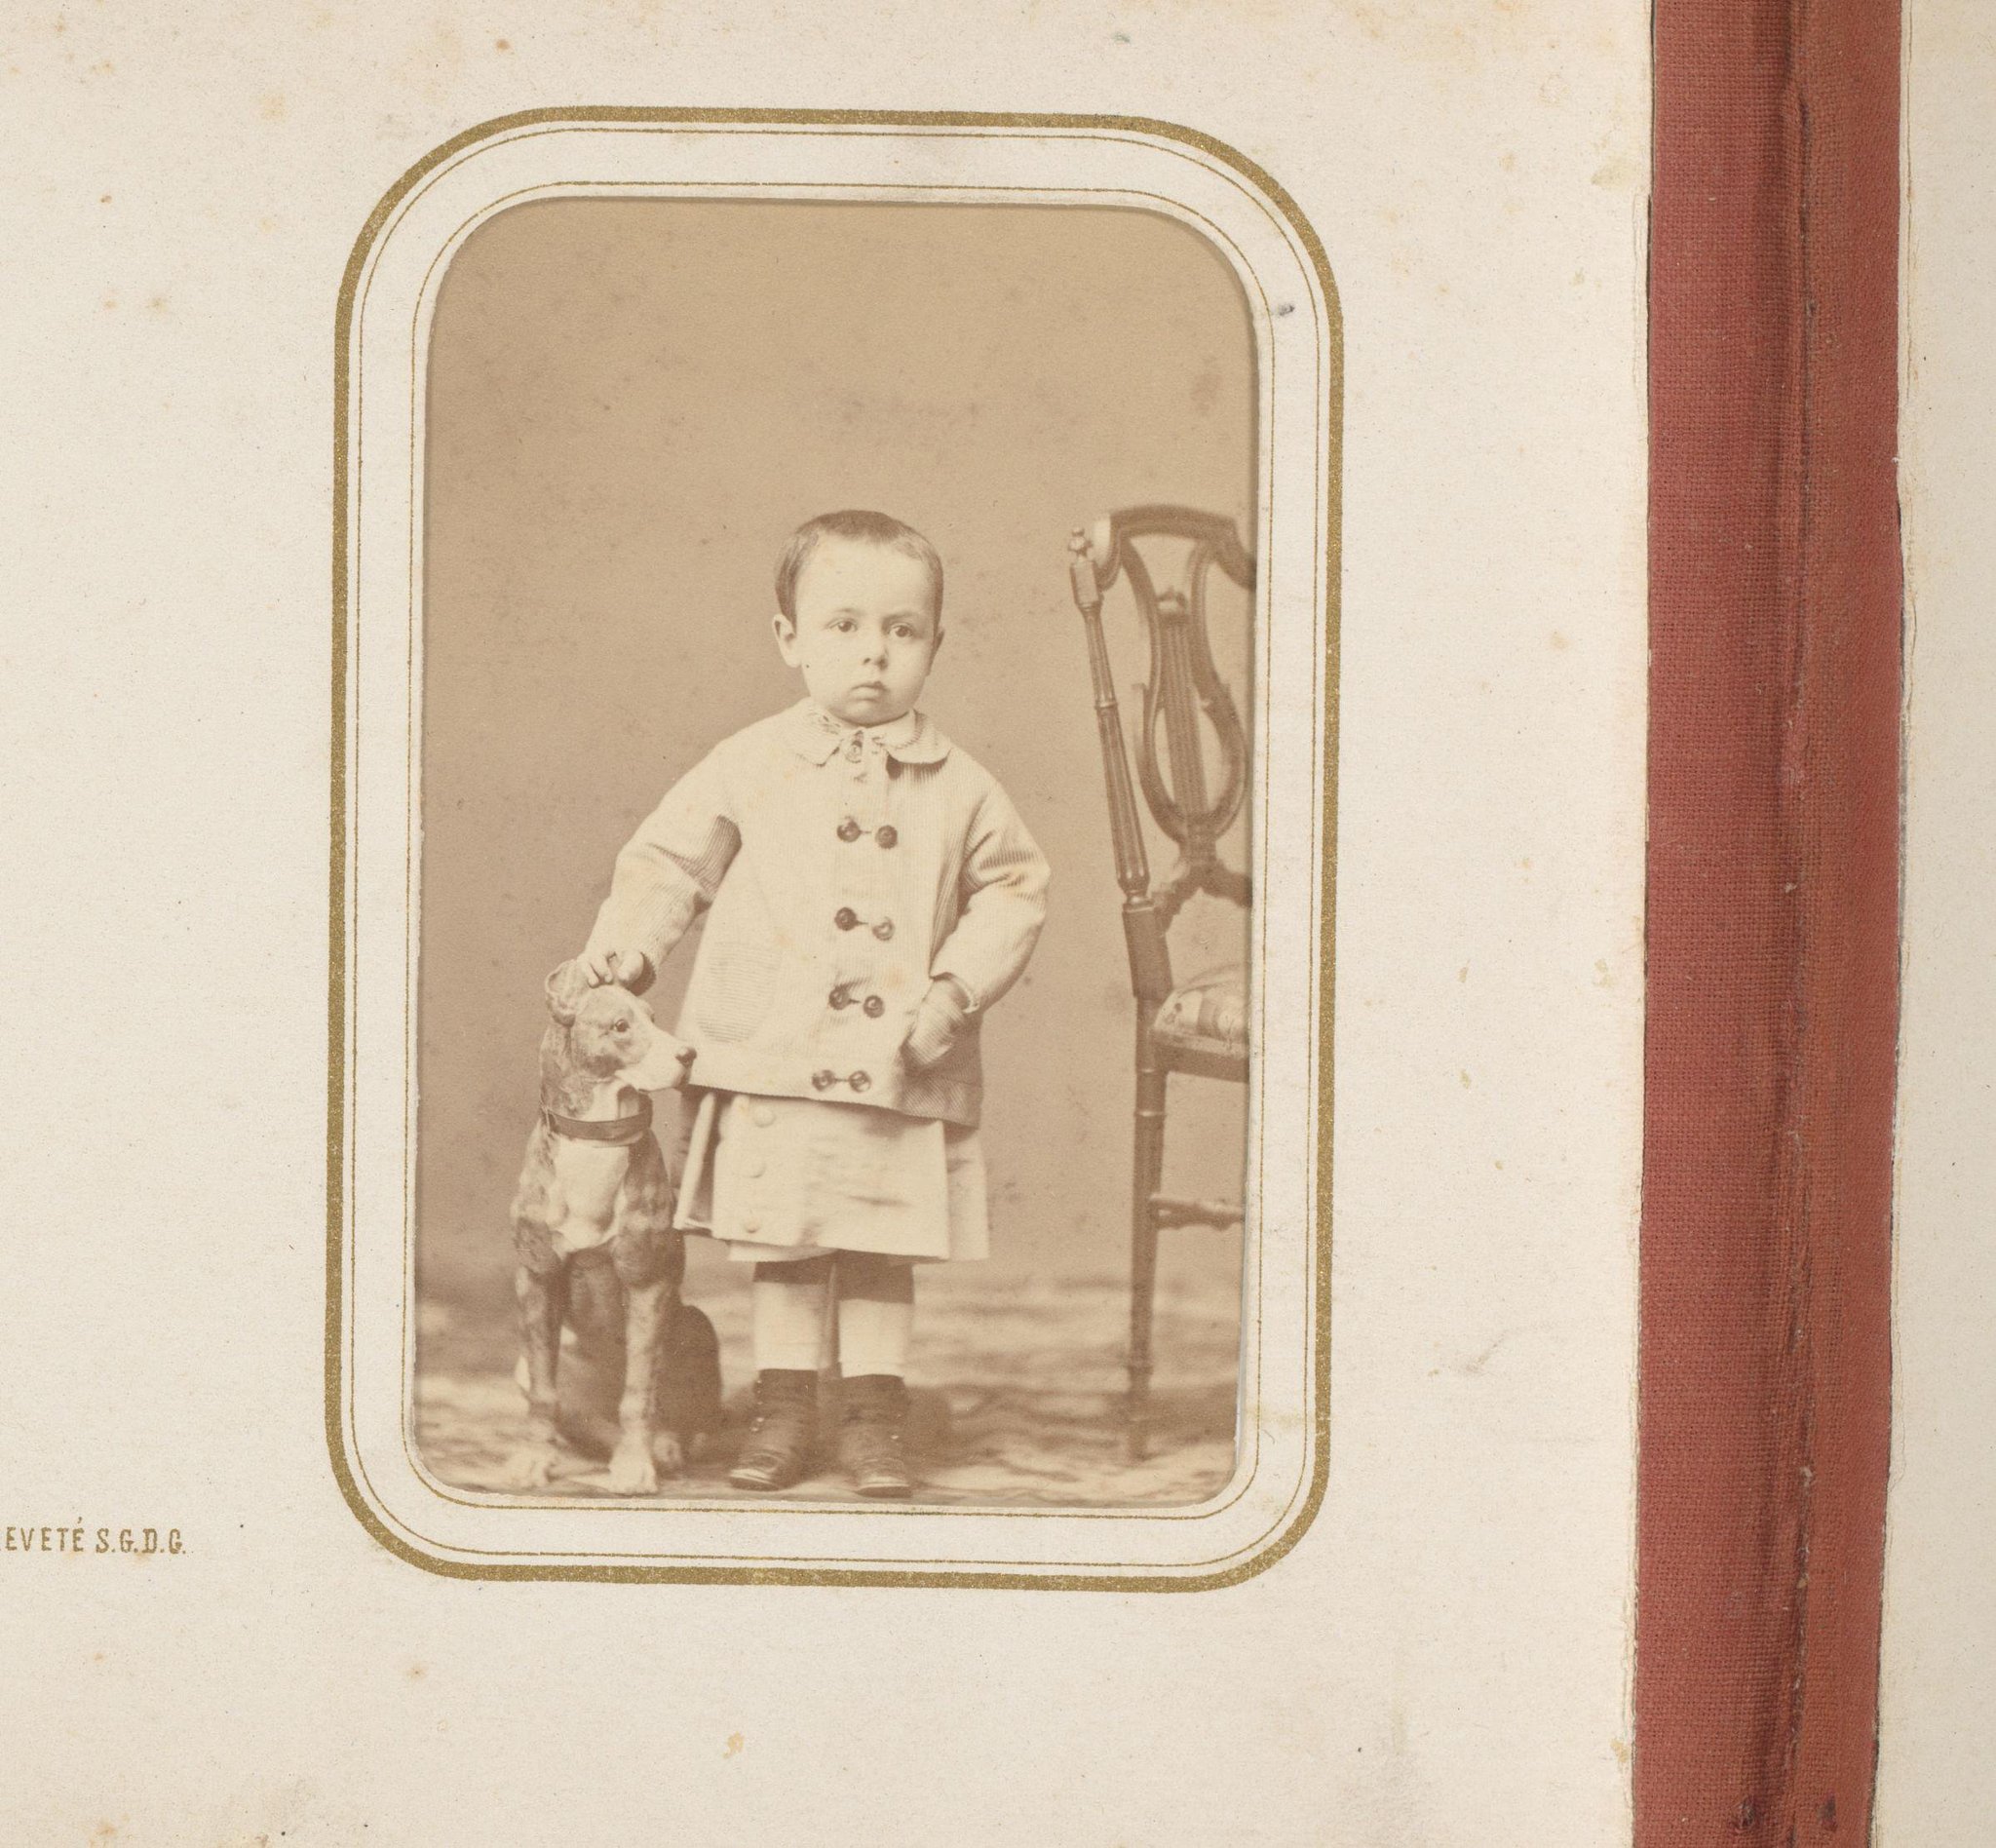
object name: album leaf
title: Portret van een kind met een hond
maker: m. de hebert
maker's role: painter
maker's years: 1819-1891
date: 1860-1891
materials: cardboard, photographic support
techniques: albumen print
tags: toddler, historical persons, dog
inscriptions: inscription: ‘M. de Hebert/ Miniaturista y fotógrafo(...)/ Ce del Prado No. 103o/ Madrid’